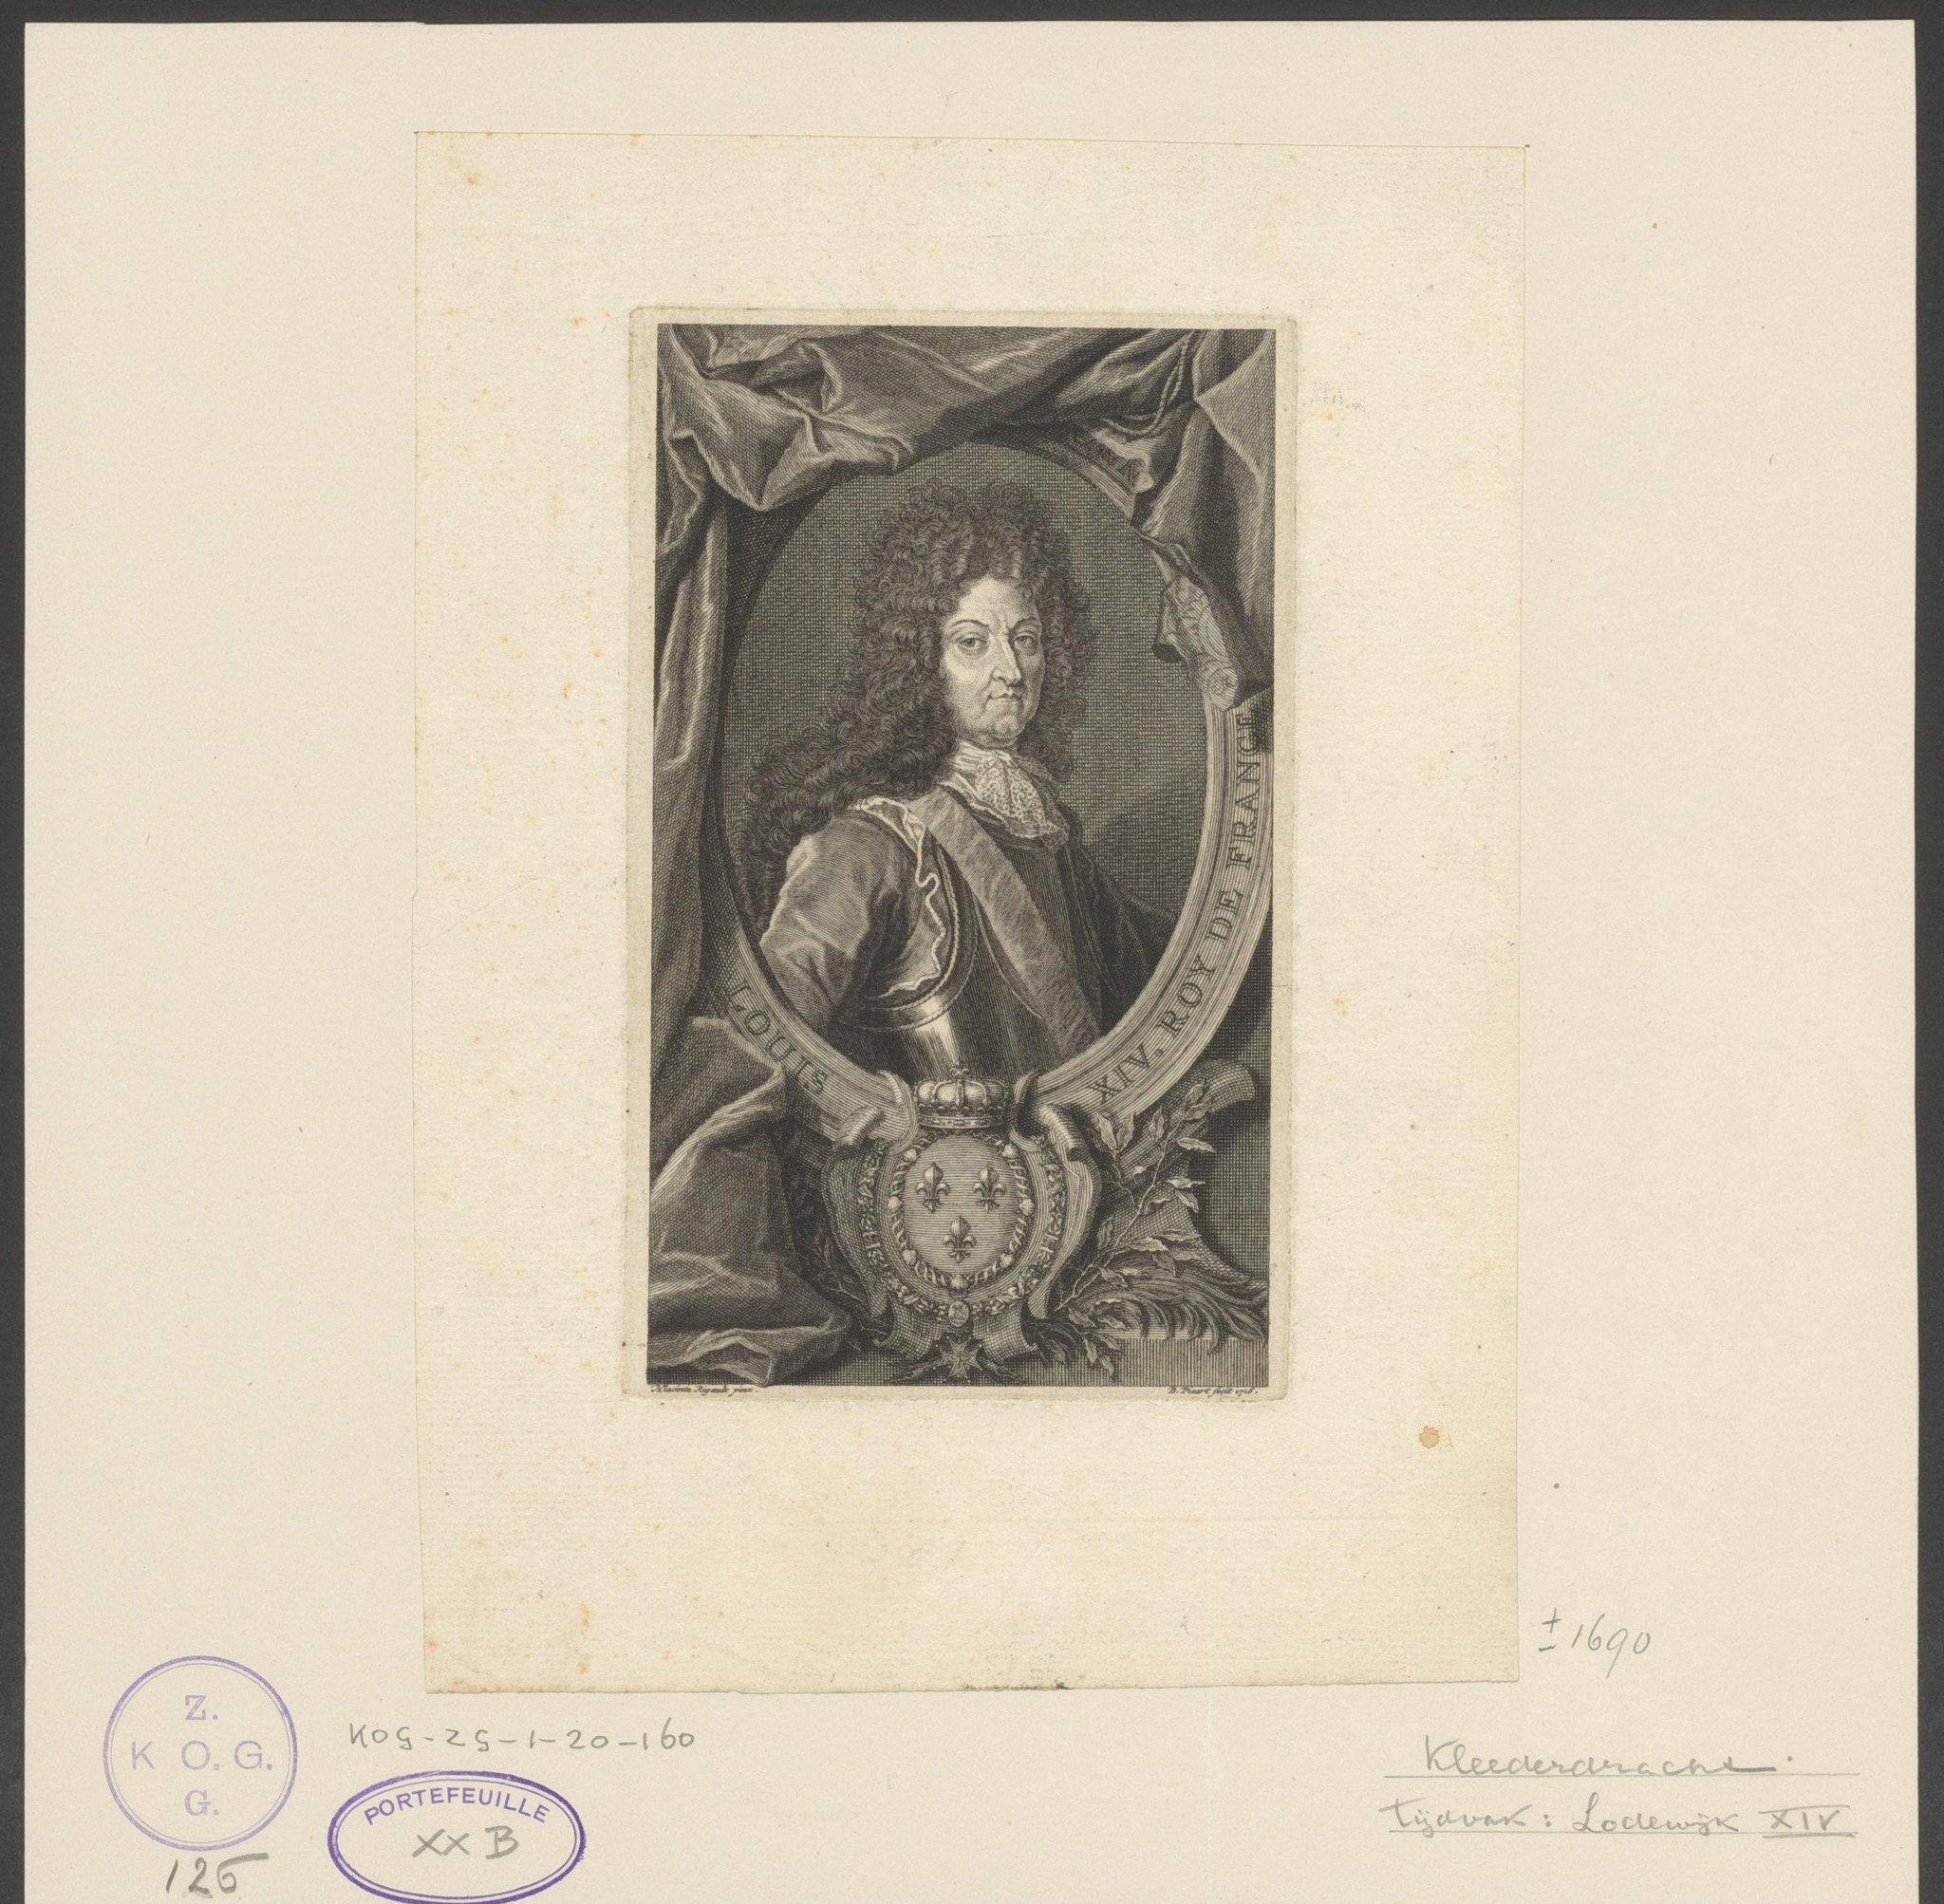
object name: print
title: Portret van Lodewijk XIV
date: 1716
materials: paper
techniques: engraving, etching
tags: lodewijk xiv (koning van frankrijk), coat of arms (symbol of sovereignty), knighthood order of the holy spirit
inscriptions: stamp, collector's mark: Lugt 1641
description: Portret van Lodewijk XIV, koning van Frankrijk. Onder de omlijsting een olijftak en zijn wapenschild waaraan een hanger van de Orde van de Heilige Geest. Onderwerpsrubrieken binnen de Atlas Zeden en Gewoonten: Zeden en Gewoonten in Engeren Zin, De Kleeding, Kleederdrachten (tijdvakken), Lodewijk XIV (1650 – 1720). Het allonge tijdvak).